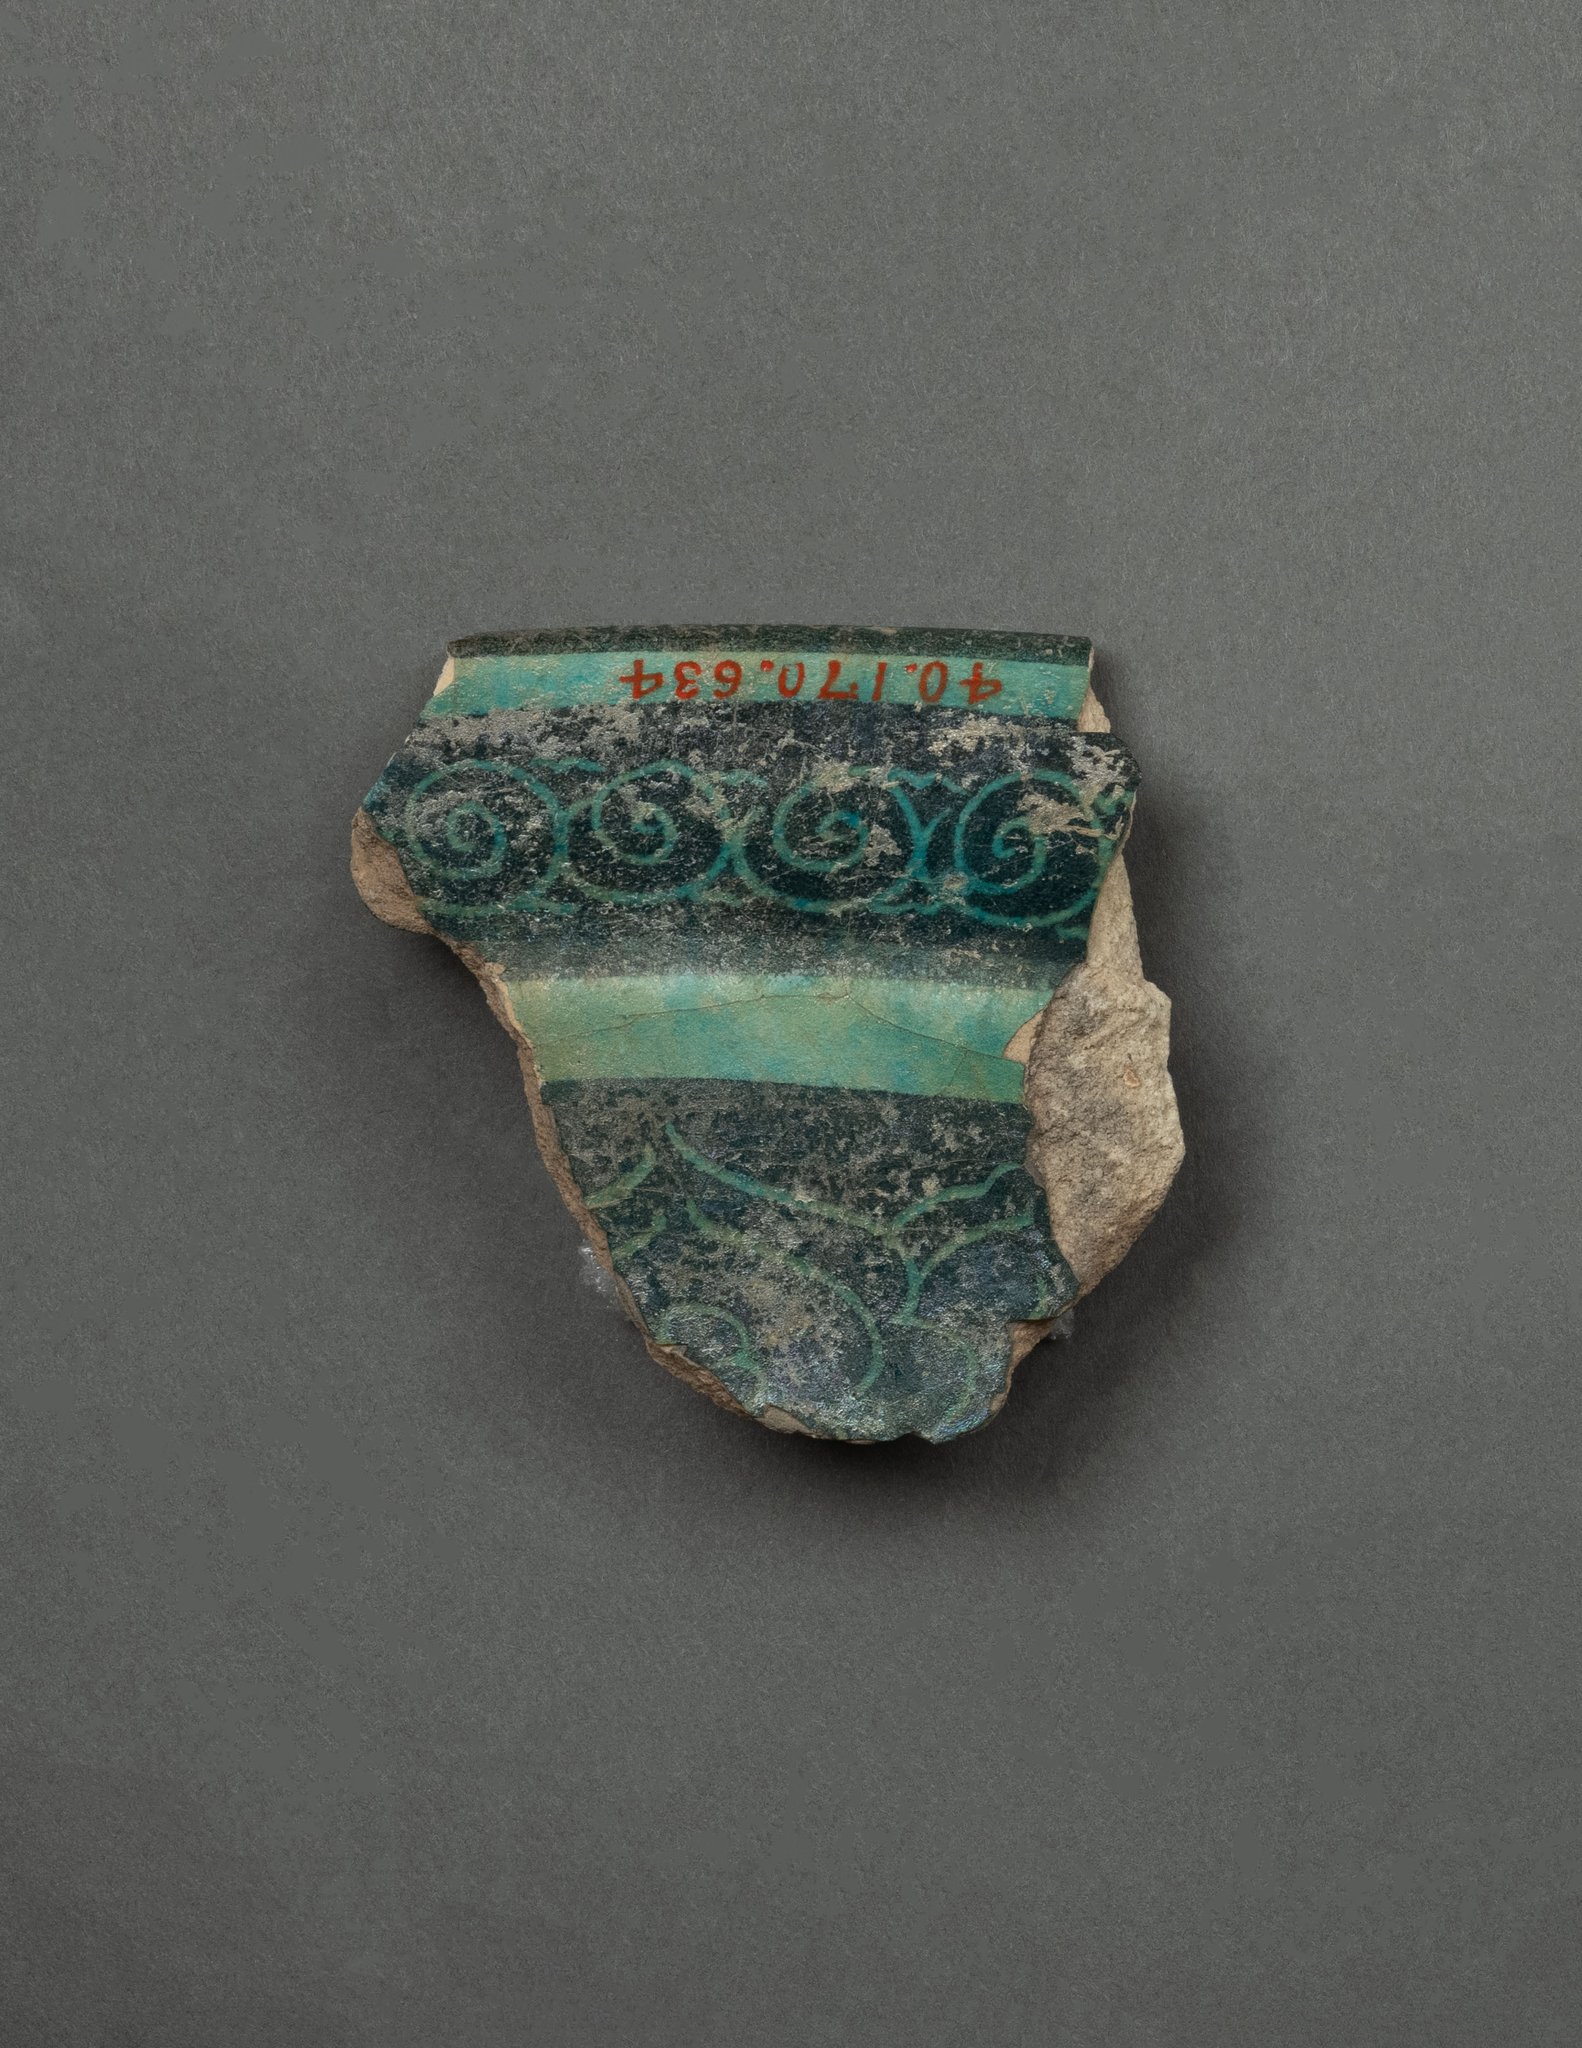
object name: fragment of a dish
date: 1401-1500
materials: earthenware, glaze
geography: iran